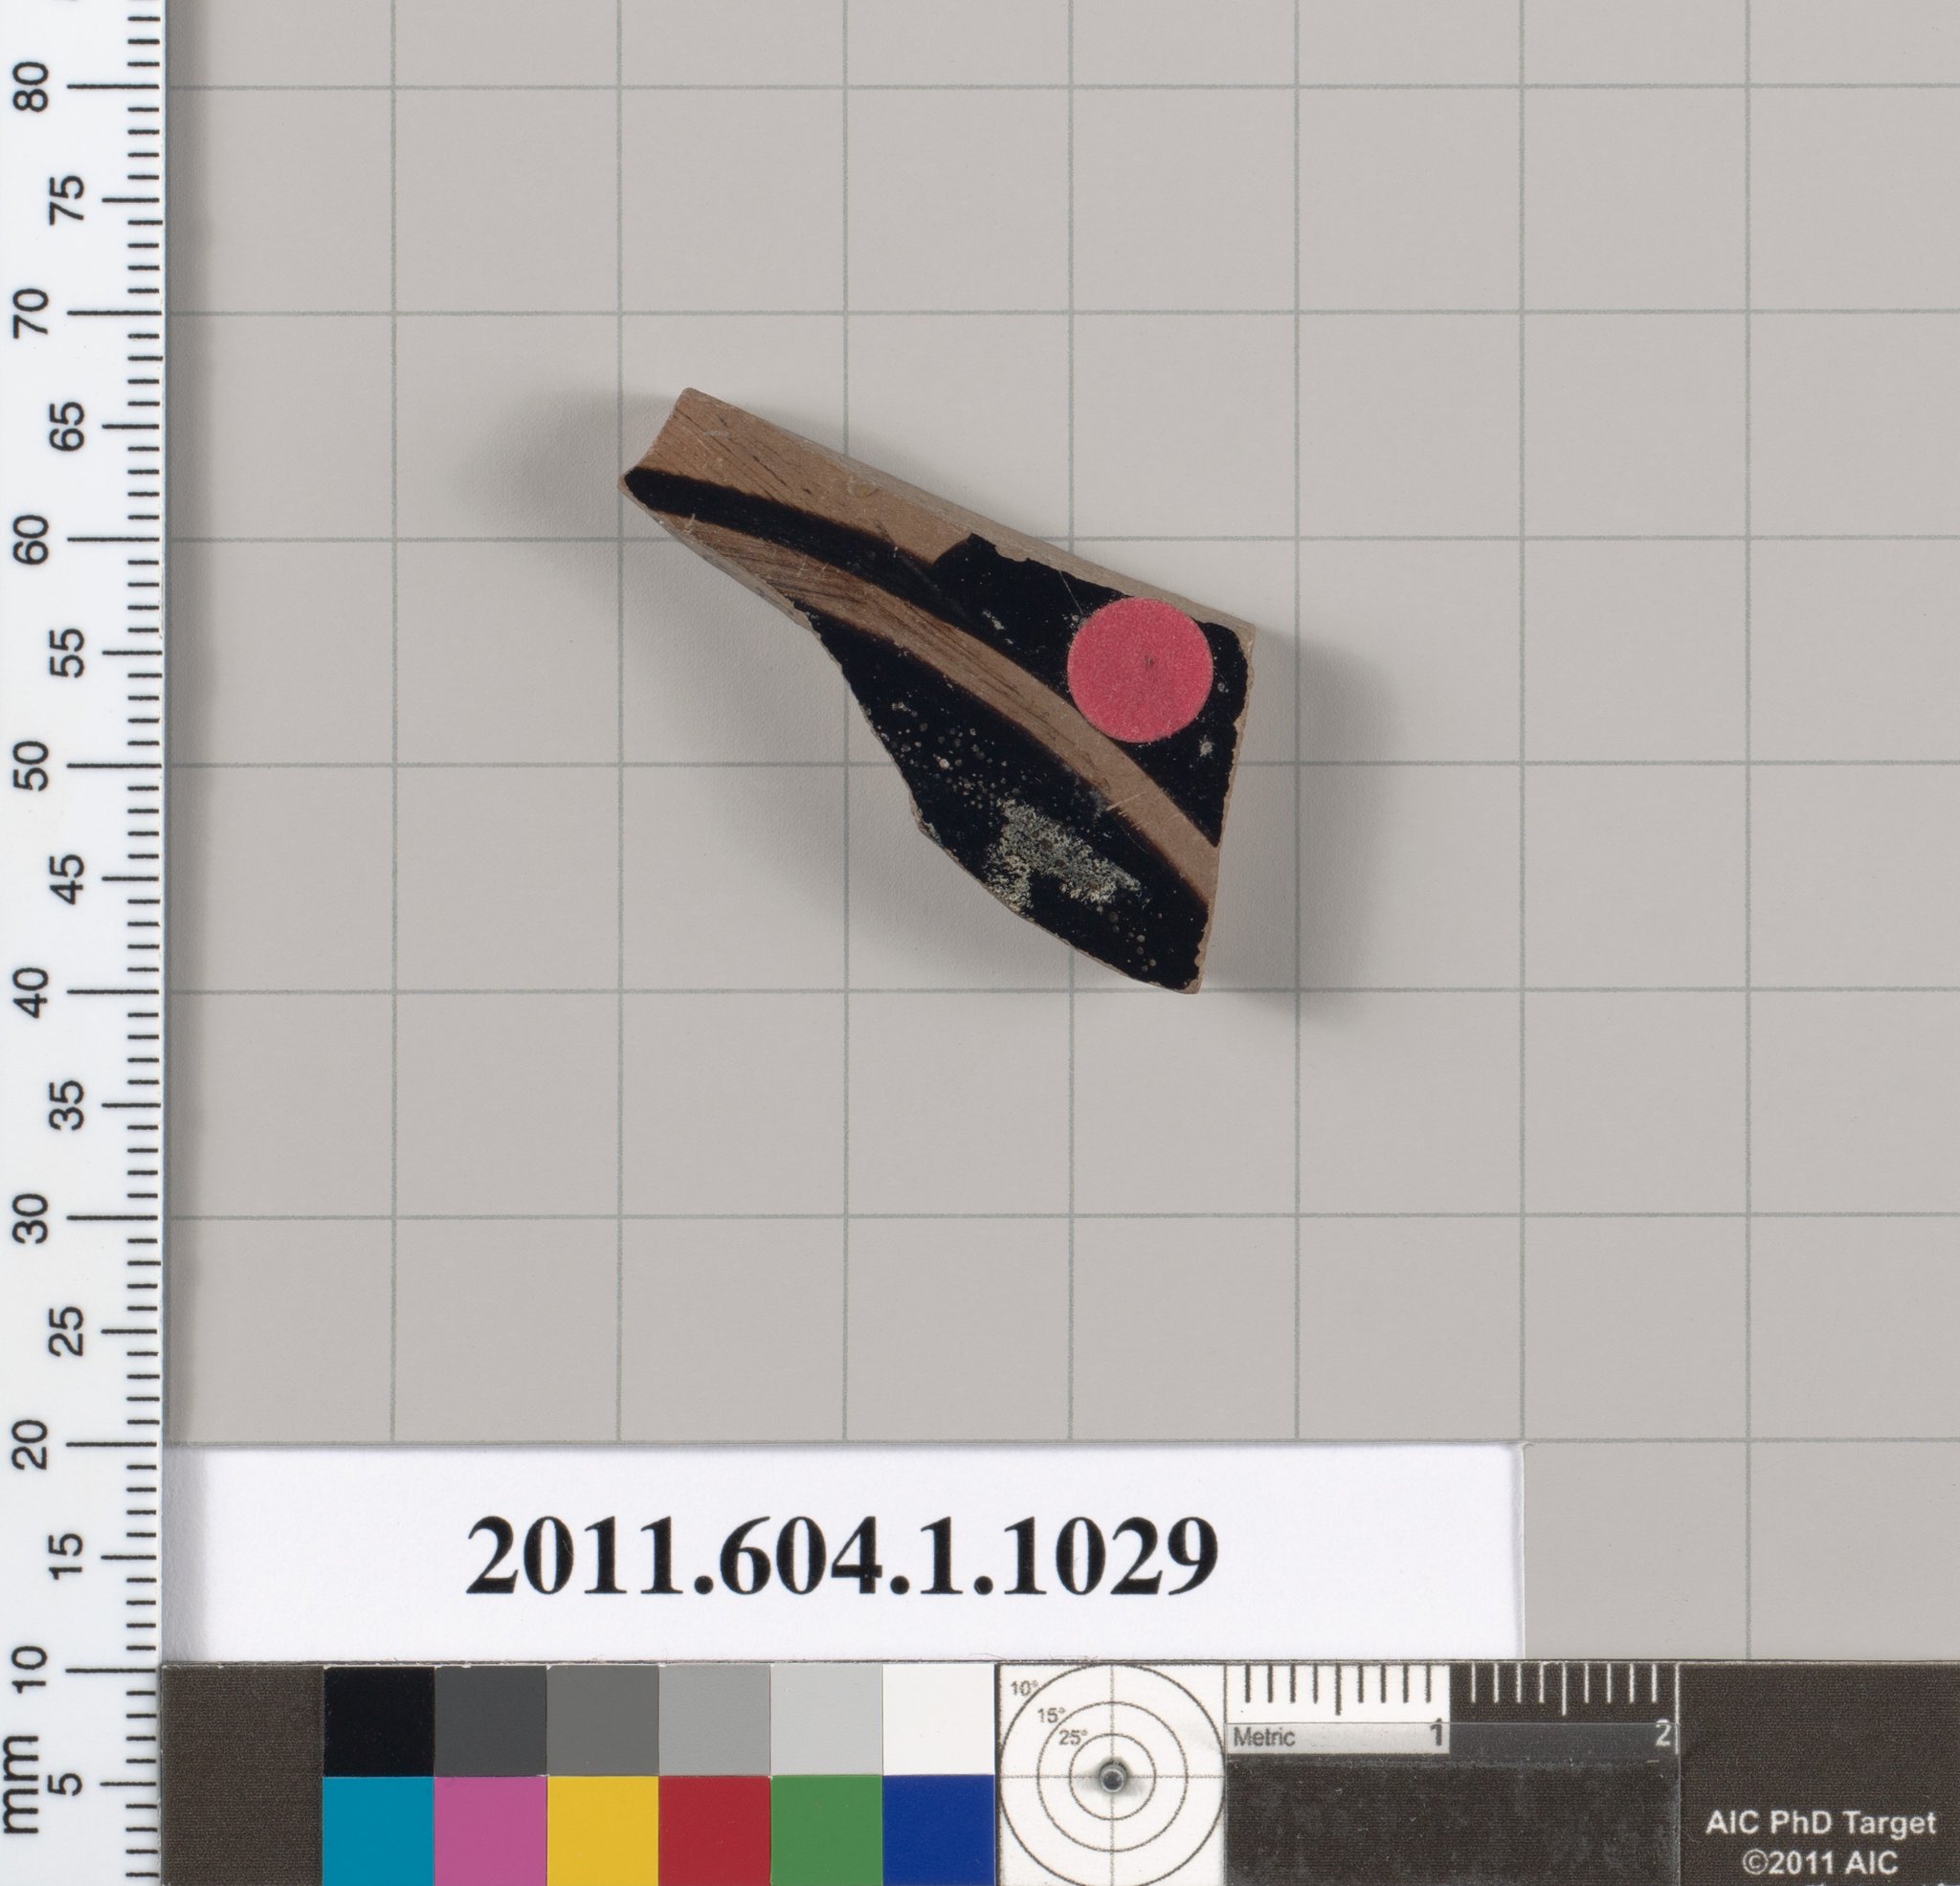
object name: kylix fragment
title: Terracotta fragment of a kylix (drinking cup)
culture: greek, attic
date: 475-451 BCE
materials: terracotta